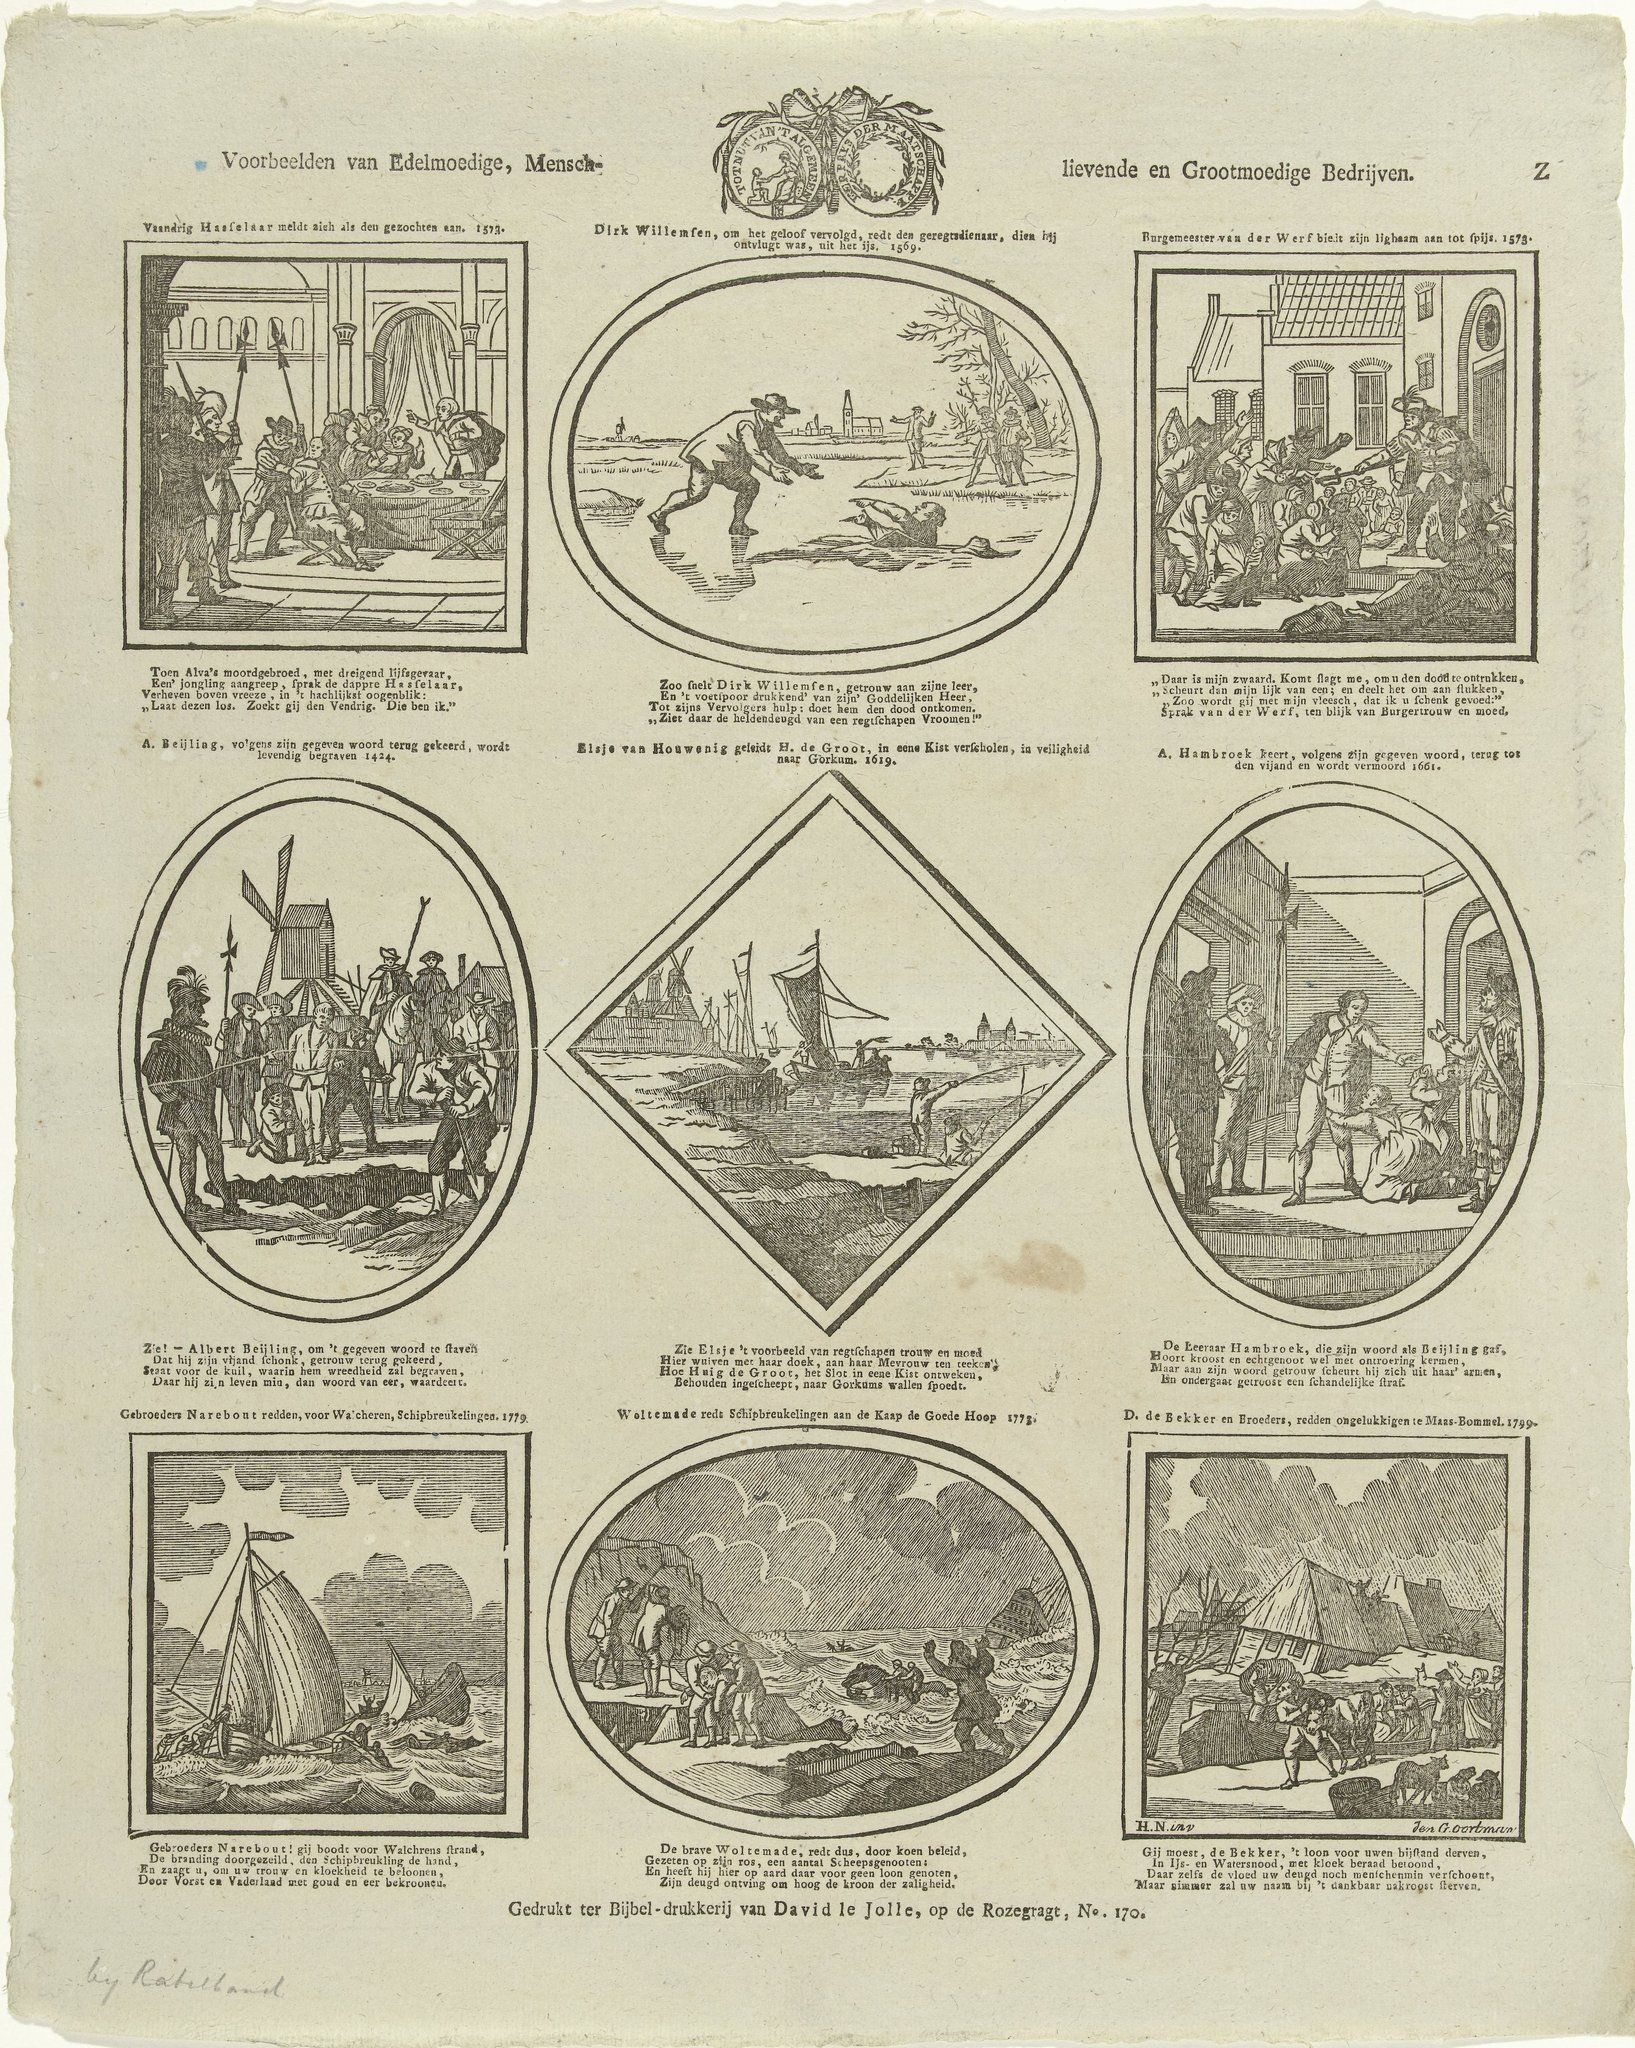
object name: print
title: Voorbeelden van edelmoedige, mensch- / lievende en grootmoedige bedrijven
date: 1814-1820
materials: paper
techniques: letterpress printing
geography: netherlands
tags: formosa, asperen, mayor, unselfishness (+ situation or event (especially in genre-painting) with symbolical connotation)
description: Blad met 9 voorstellingen van daden van personen uit de Nederlandse geschiedenis die getuigen van edelmoedigheid. Voorstellingen geheel of grotendeels overgenomen van oude prenten. Midden boven het zegel van de Maatschappij tot Nut van 't Algemeen. Boven elke afbeelding een titel, onder elke afbeelding een vierregelig vers. Genummerd rechtsboven: Z.